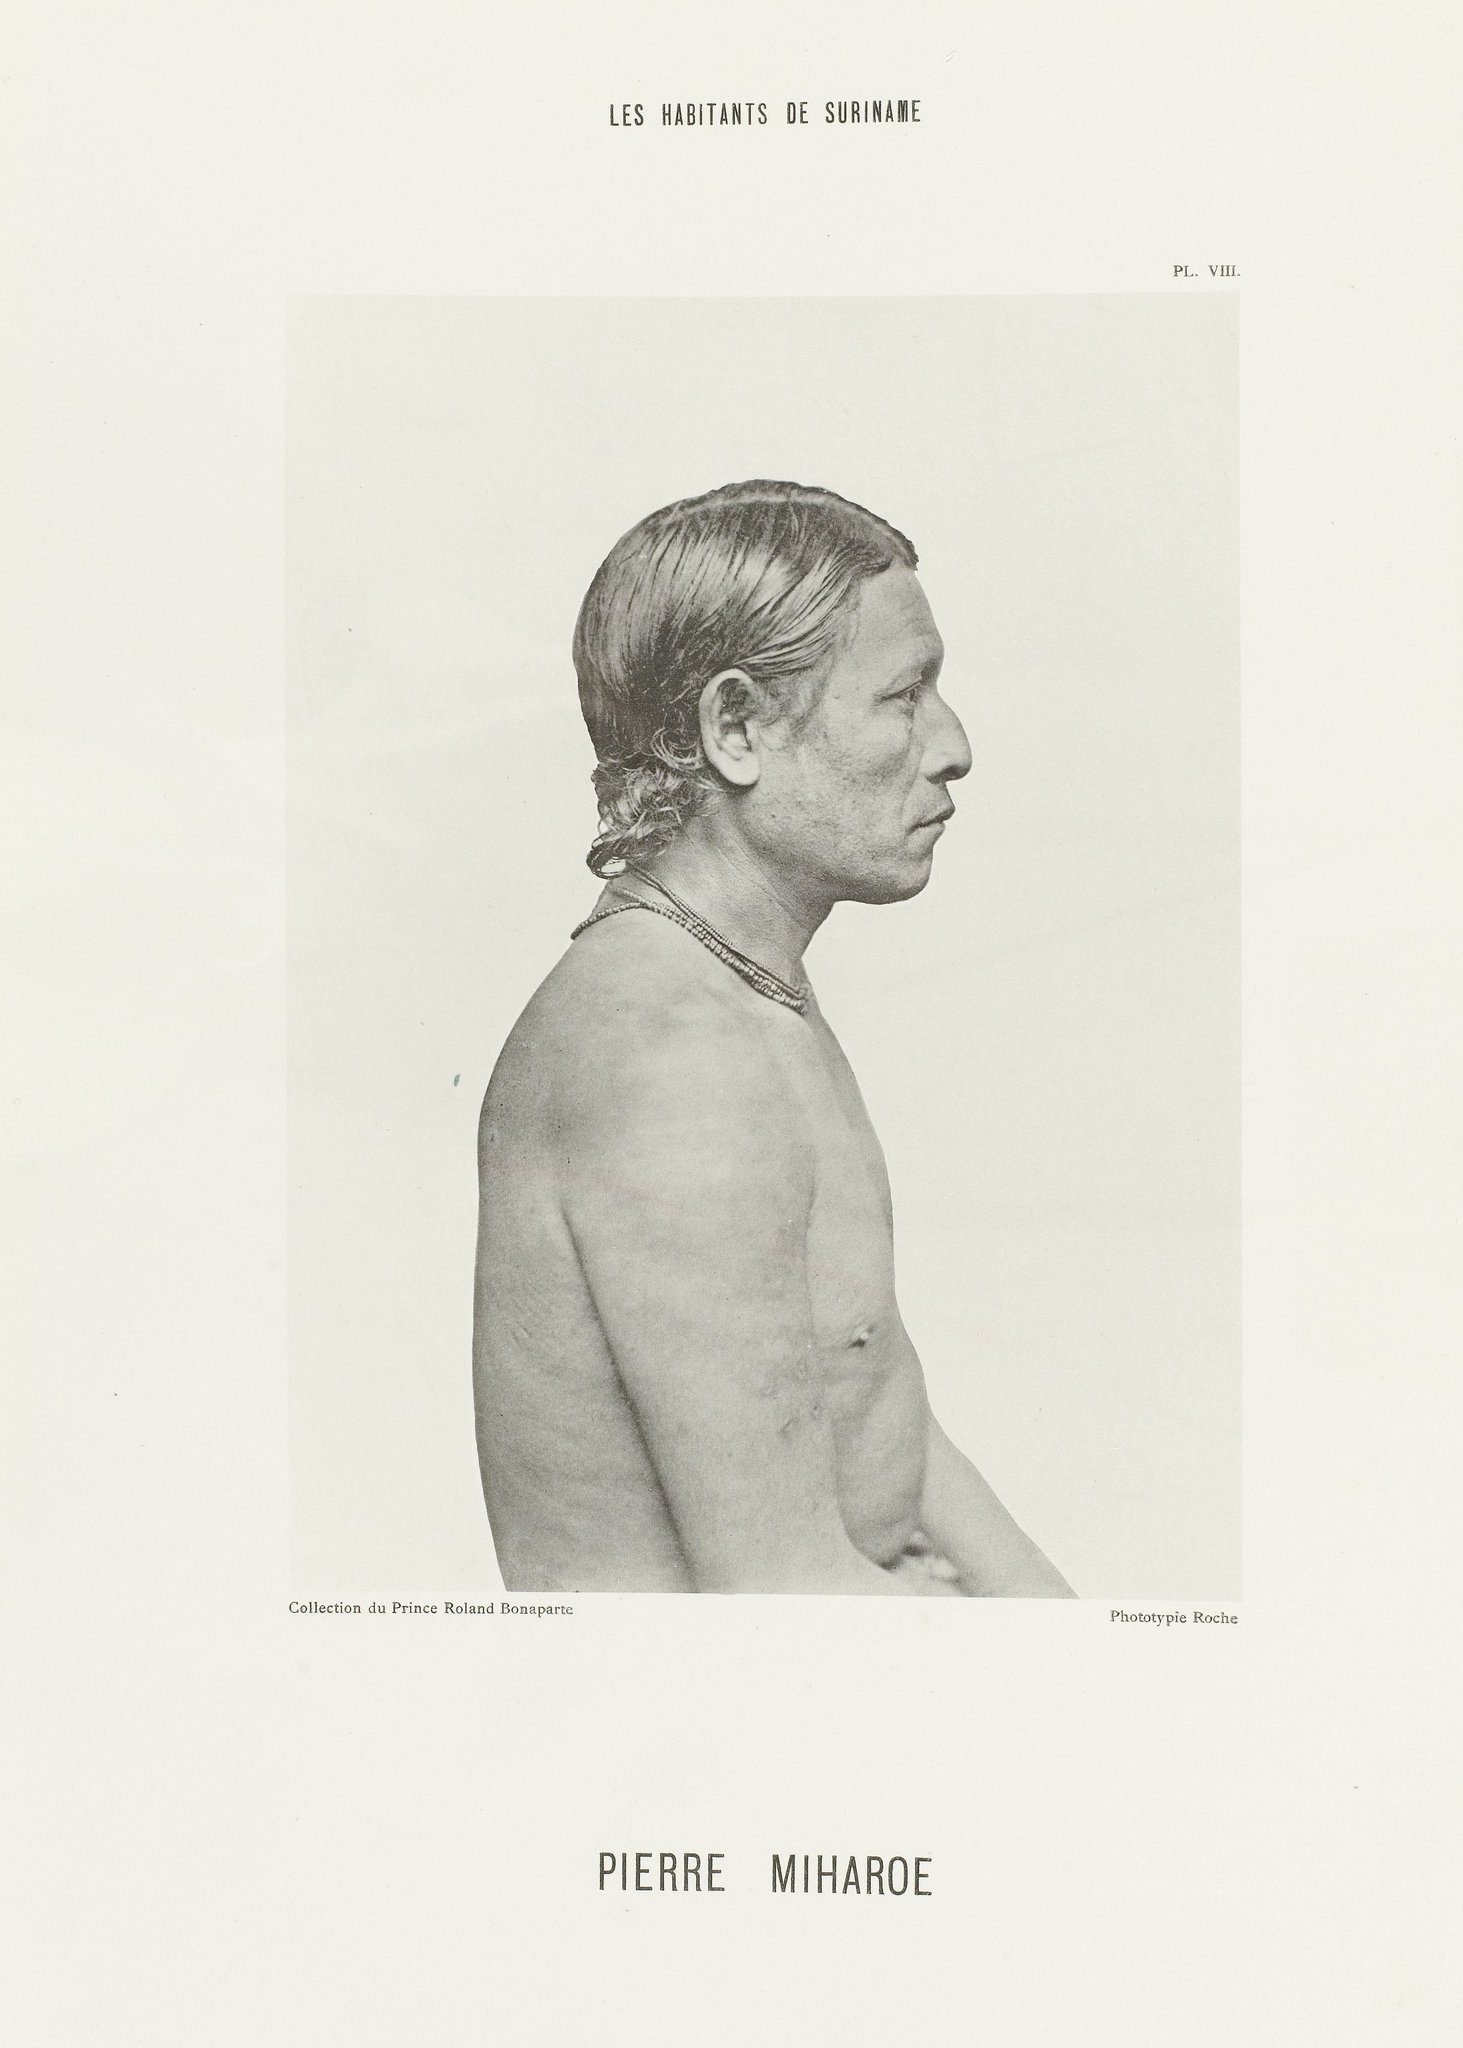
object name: photomechanical print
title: Portret van Pierre Miharoe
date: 1883-1884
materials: paper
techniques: photograph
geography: amsterdam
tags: adult man, historical persons, indigenous peoples of south america, amsterdam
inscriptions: inscription: ‘Collection du Prince Roland Bonaparte/ Phototypie Roche’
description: Portret van Pierre Miharoe, een Caraïb uit Suriname, gefotografeerd op de Internationale Koloniale en Uitvoerhandel Tentoonstelling, Amsterdam 1883.